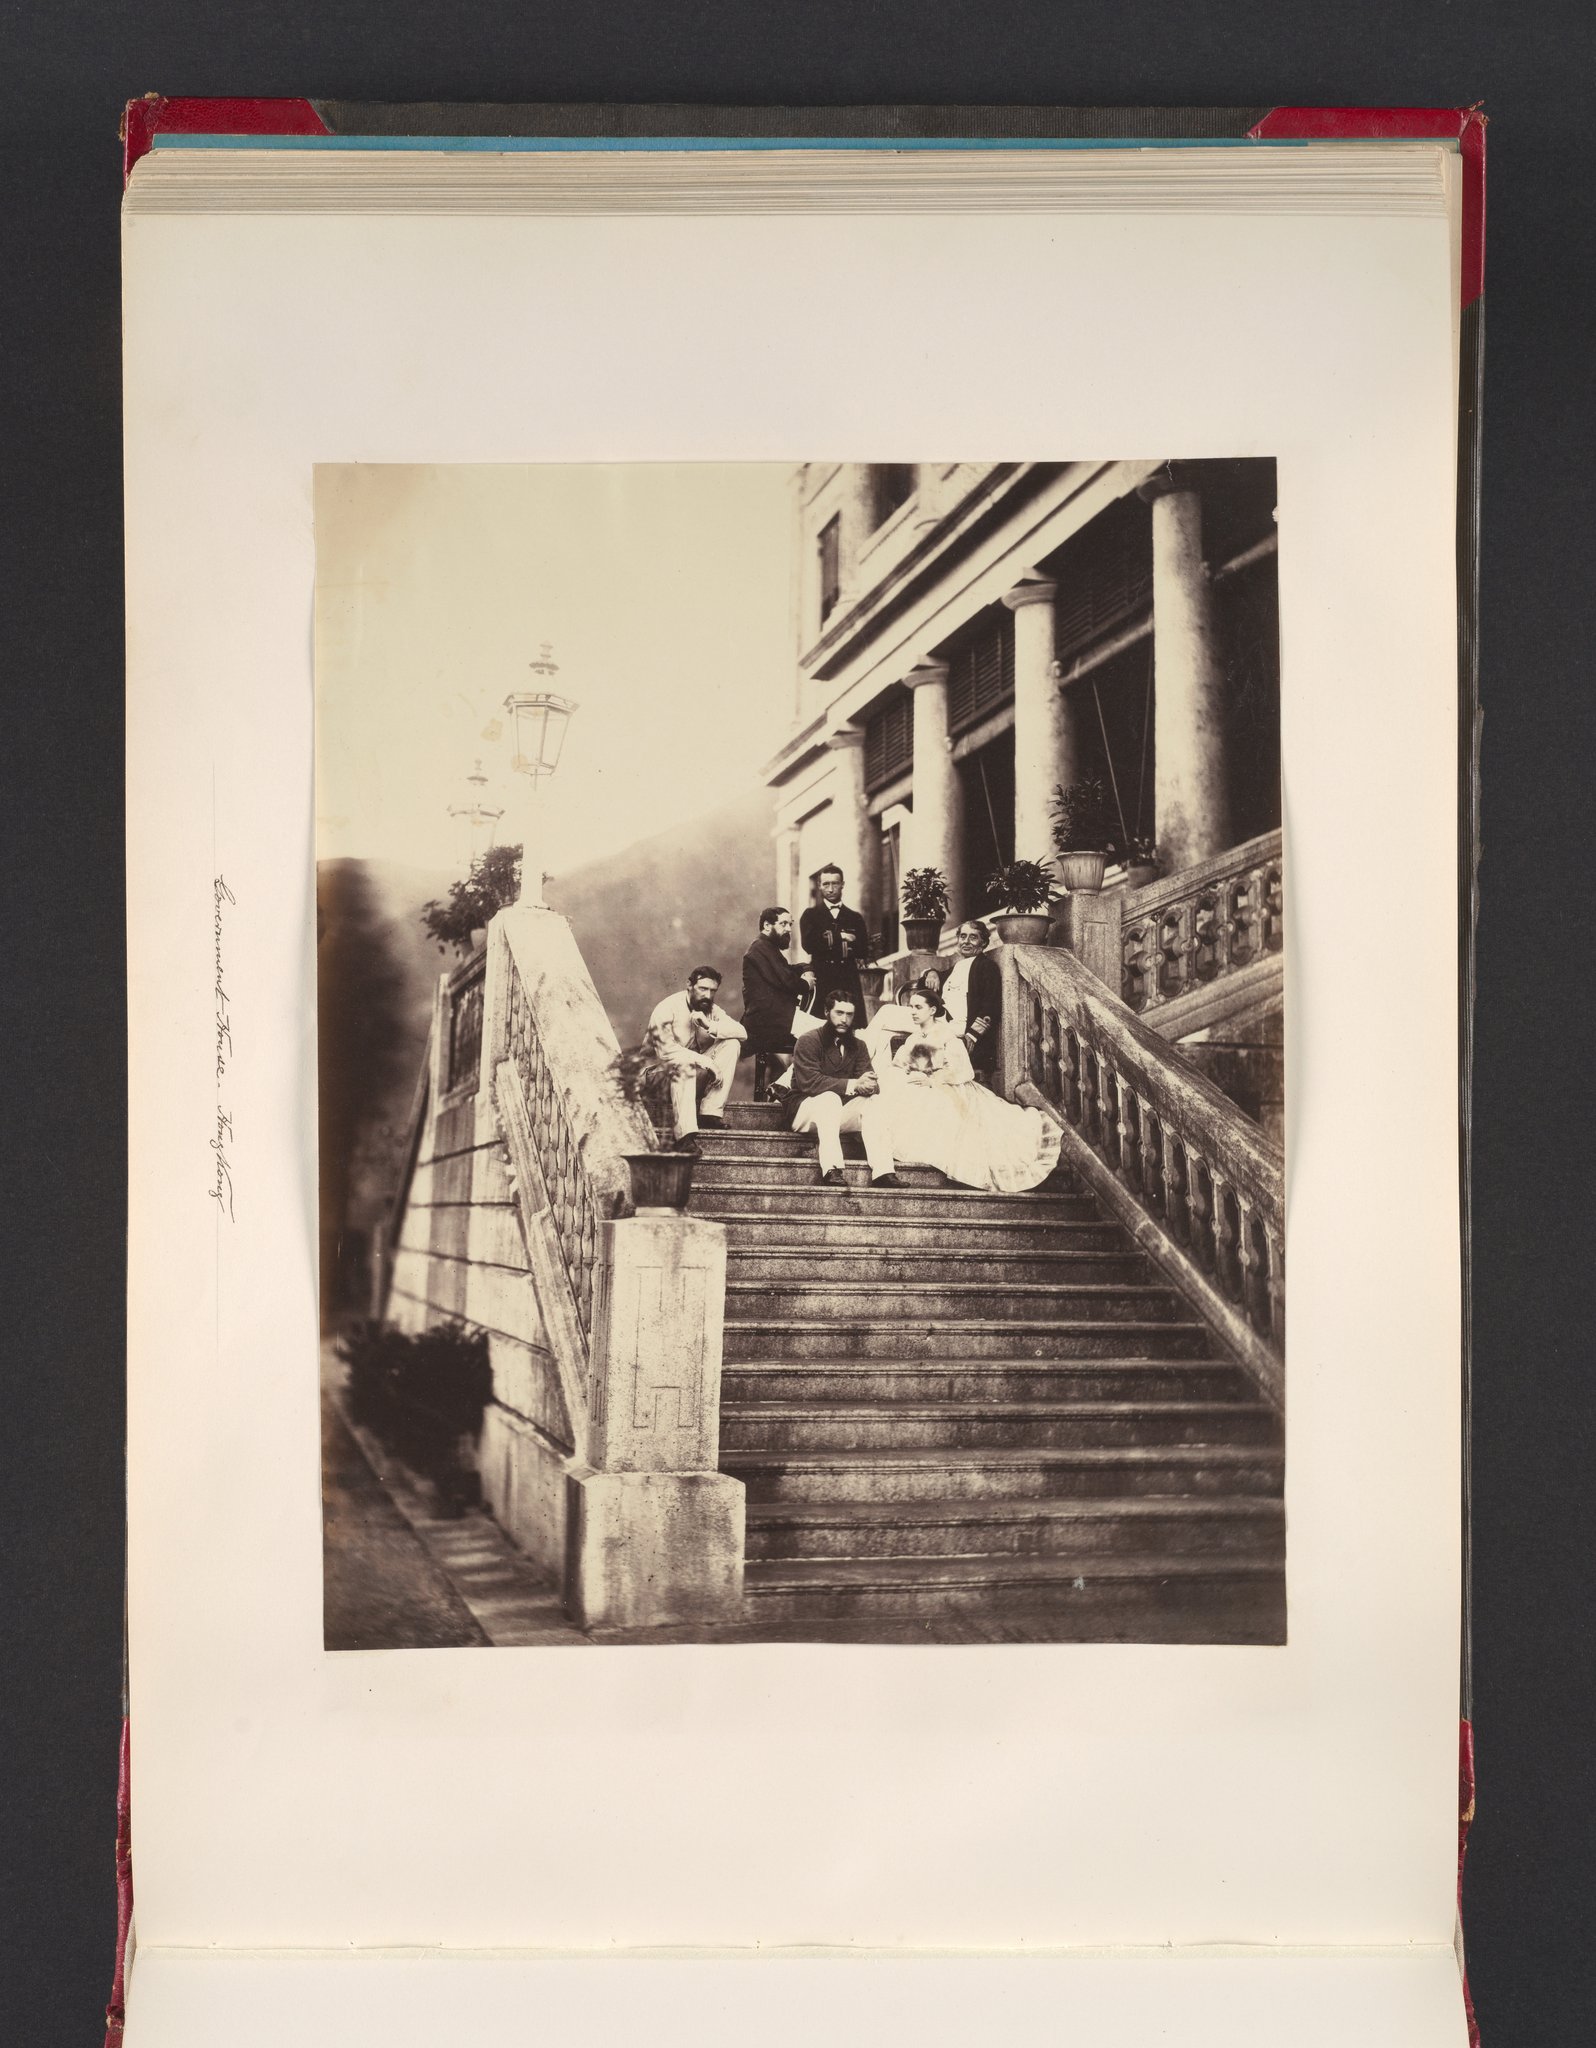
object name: photograph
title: Government House, Hong Kong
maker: john thomson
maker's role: artist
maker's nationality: british, scottish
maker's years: 1837-1921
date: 1865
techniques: albumen silver print, glass negative